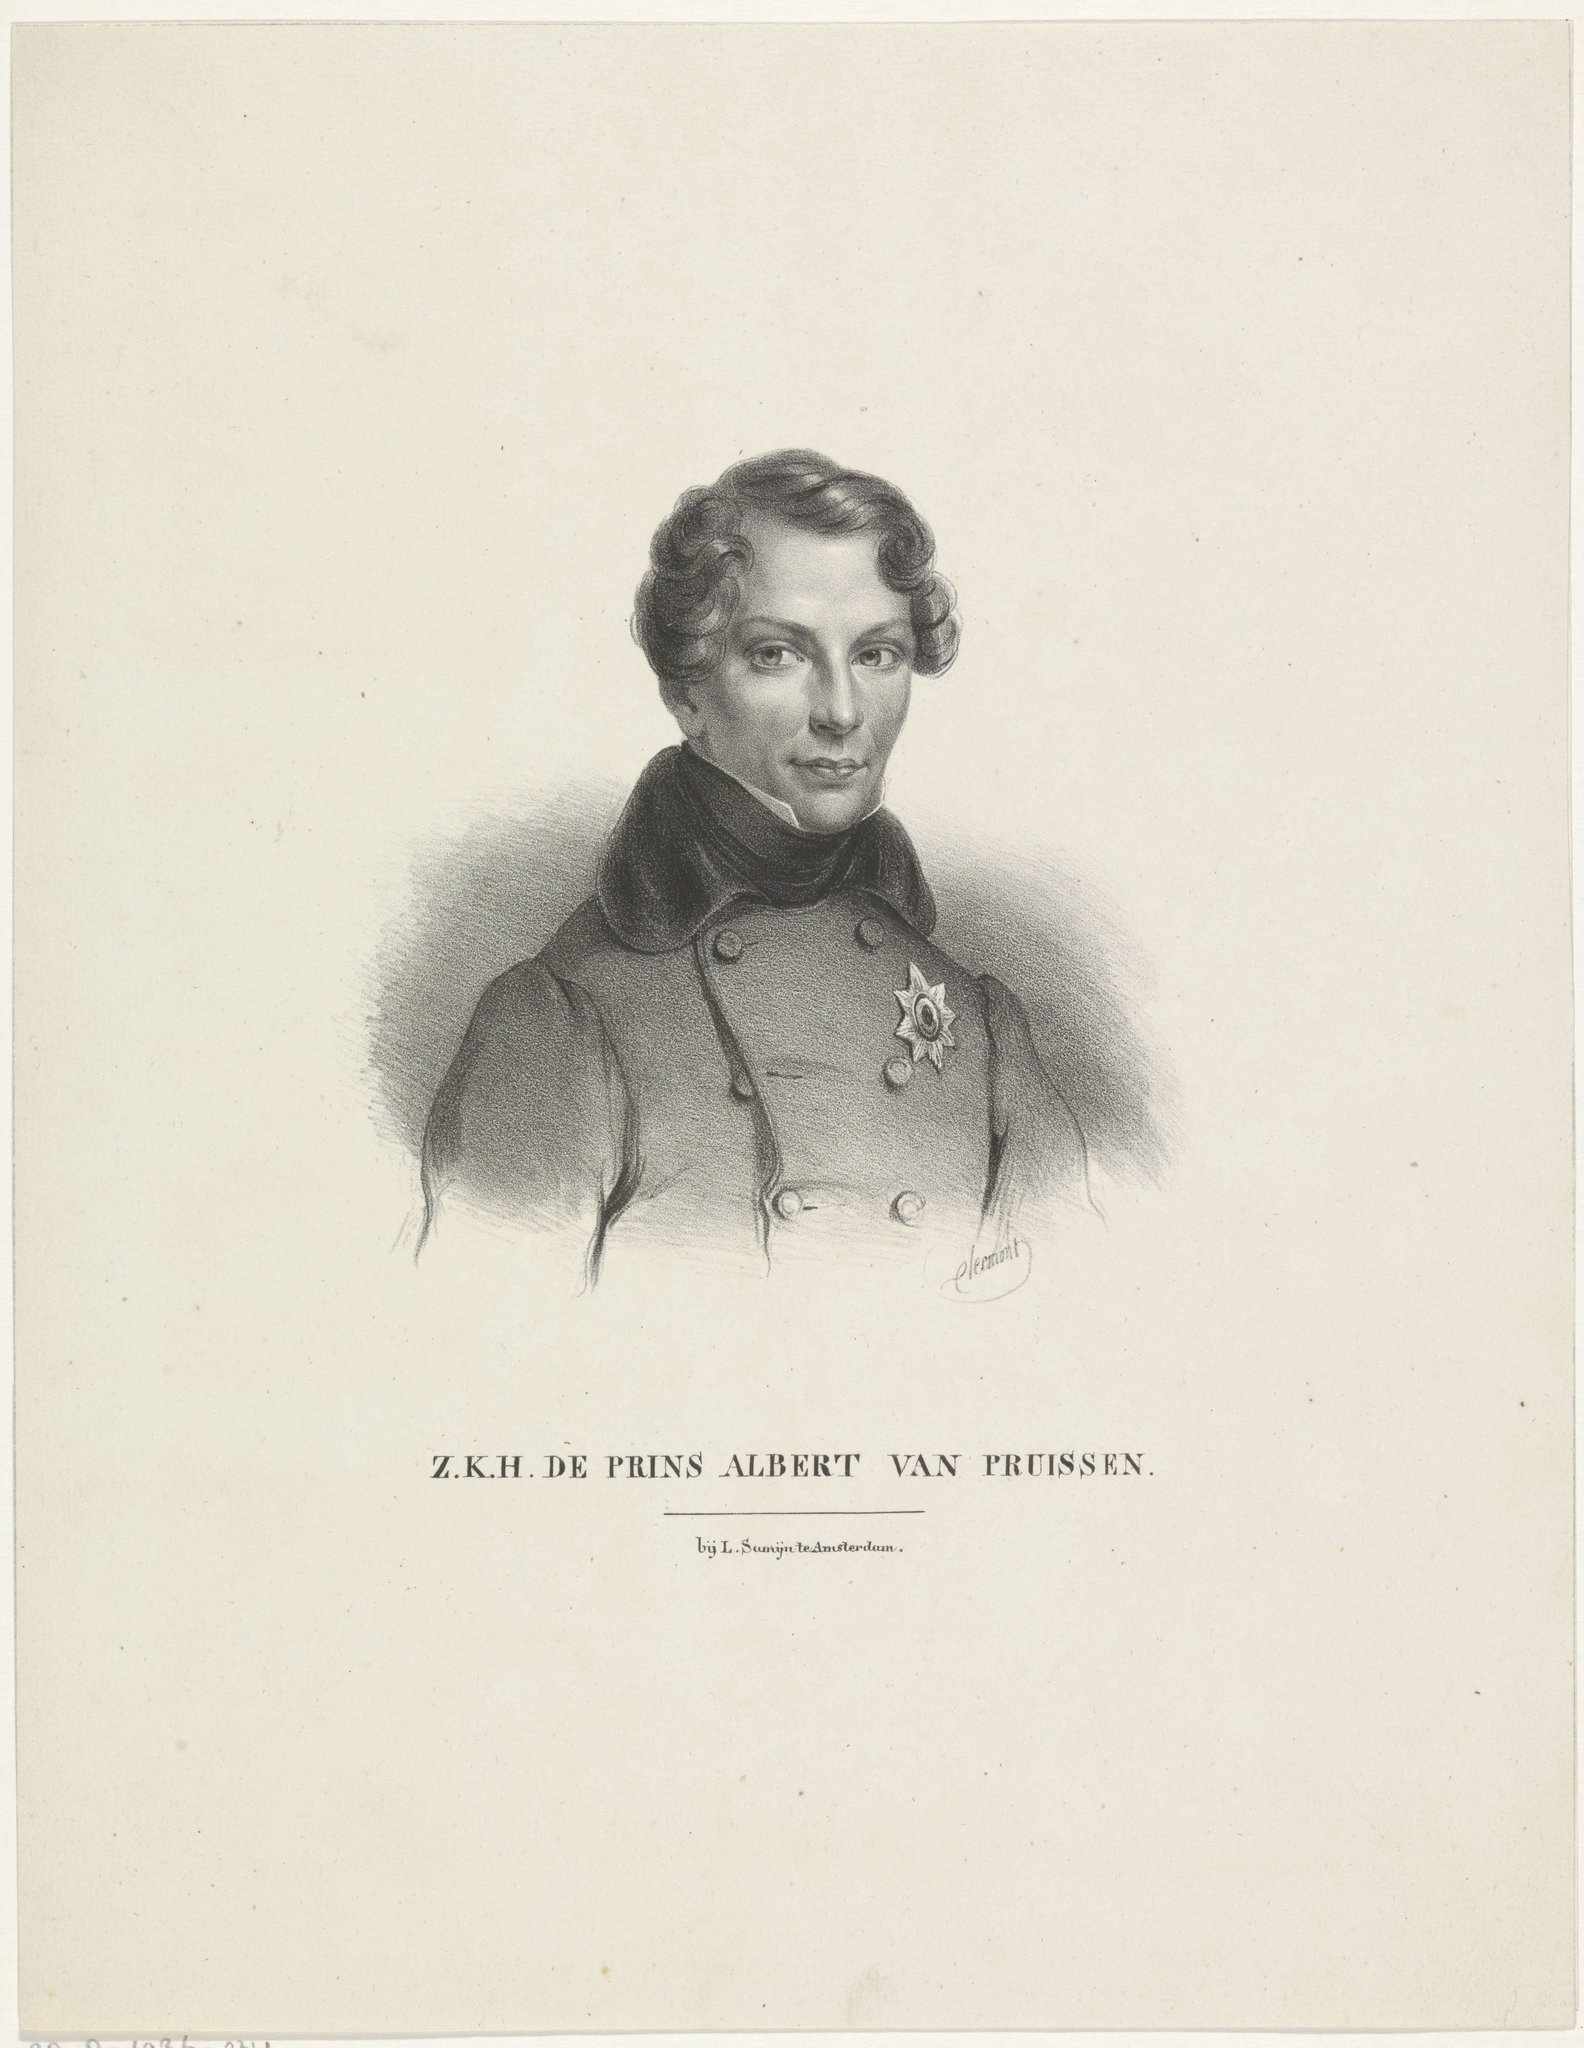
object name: print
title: Portret van Prins Albert van Pruisen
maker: j.b. clermans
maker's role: print maker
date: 1826-1839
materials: paper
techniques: lithograph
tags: berlin, knighthood order, historical persons (+ (full) bust portrait)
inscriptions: collector's mark: Lugt 2228, collector's mark: Lugt 2760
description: De geportretteerde draagt een jas waarvan een knop niet is vastgemaakt. Op zijn borst draagt hij een ridderorde. Onder het portret zijn naam.